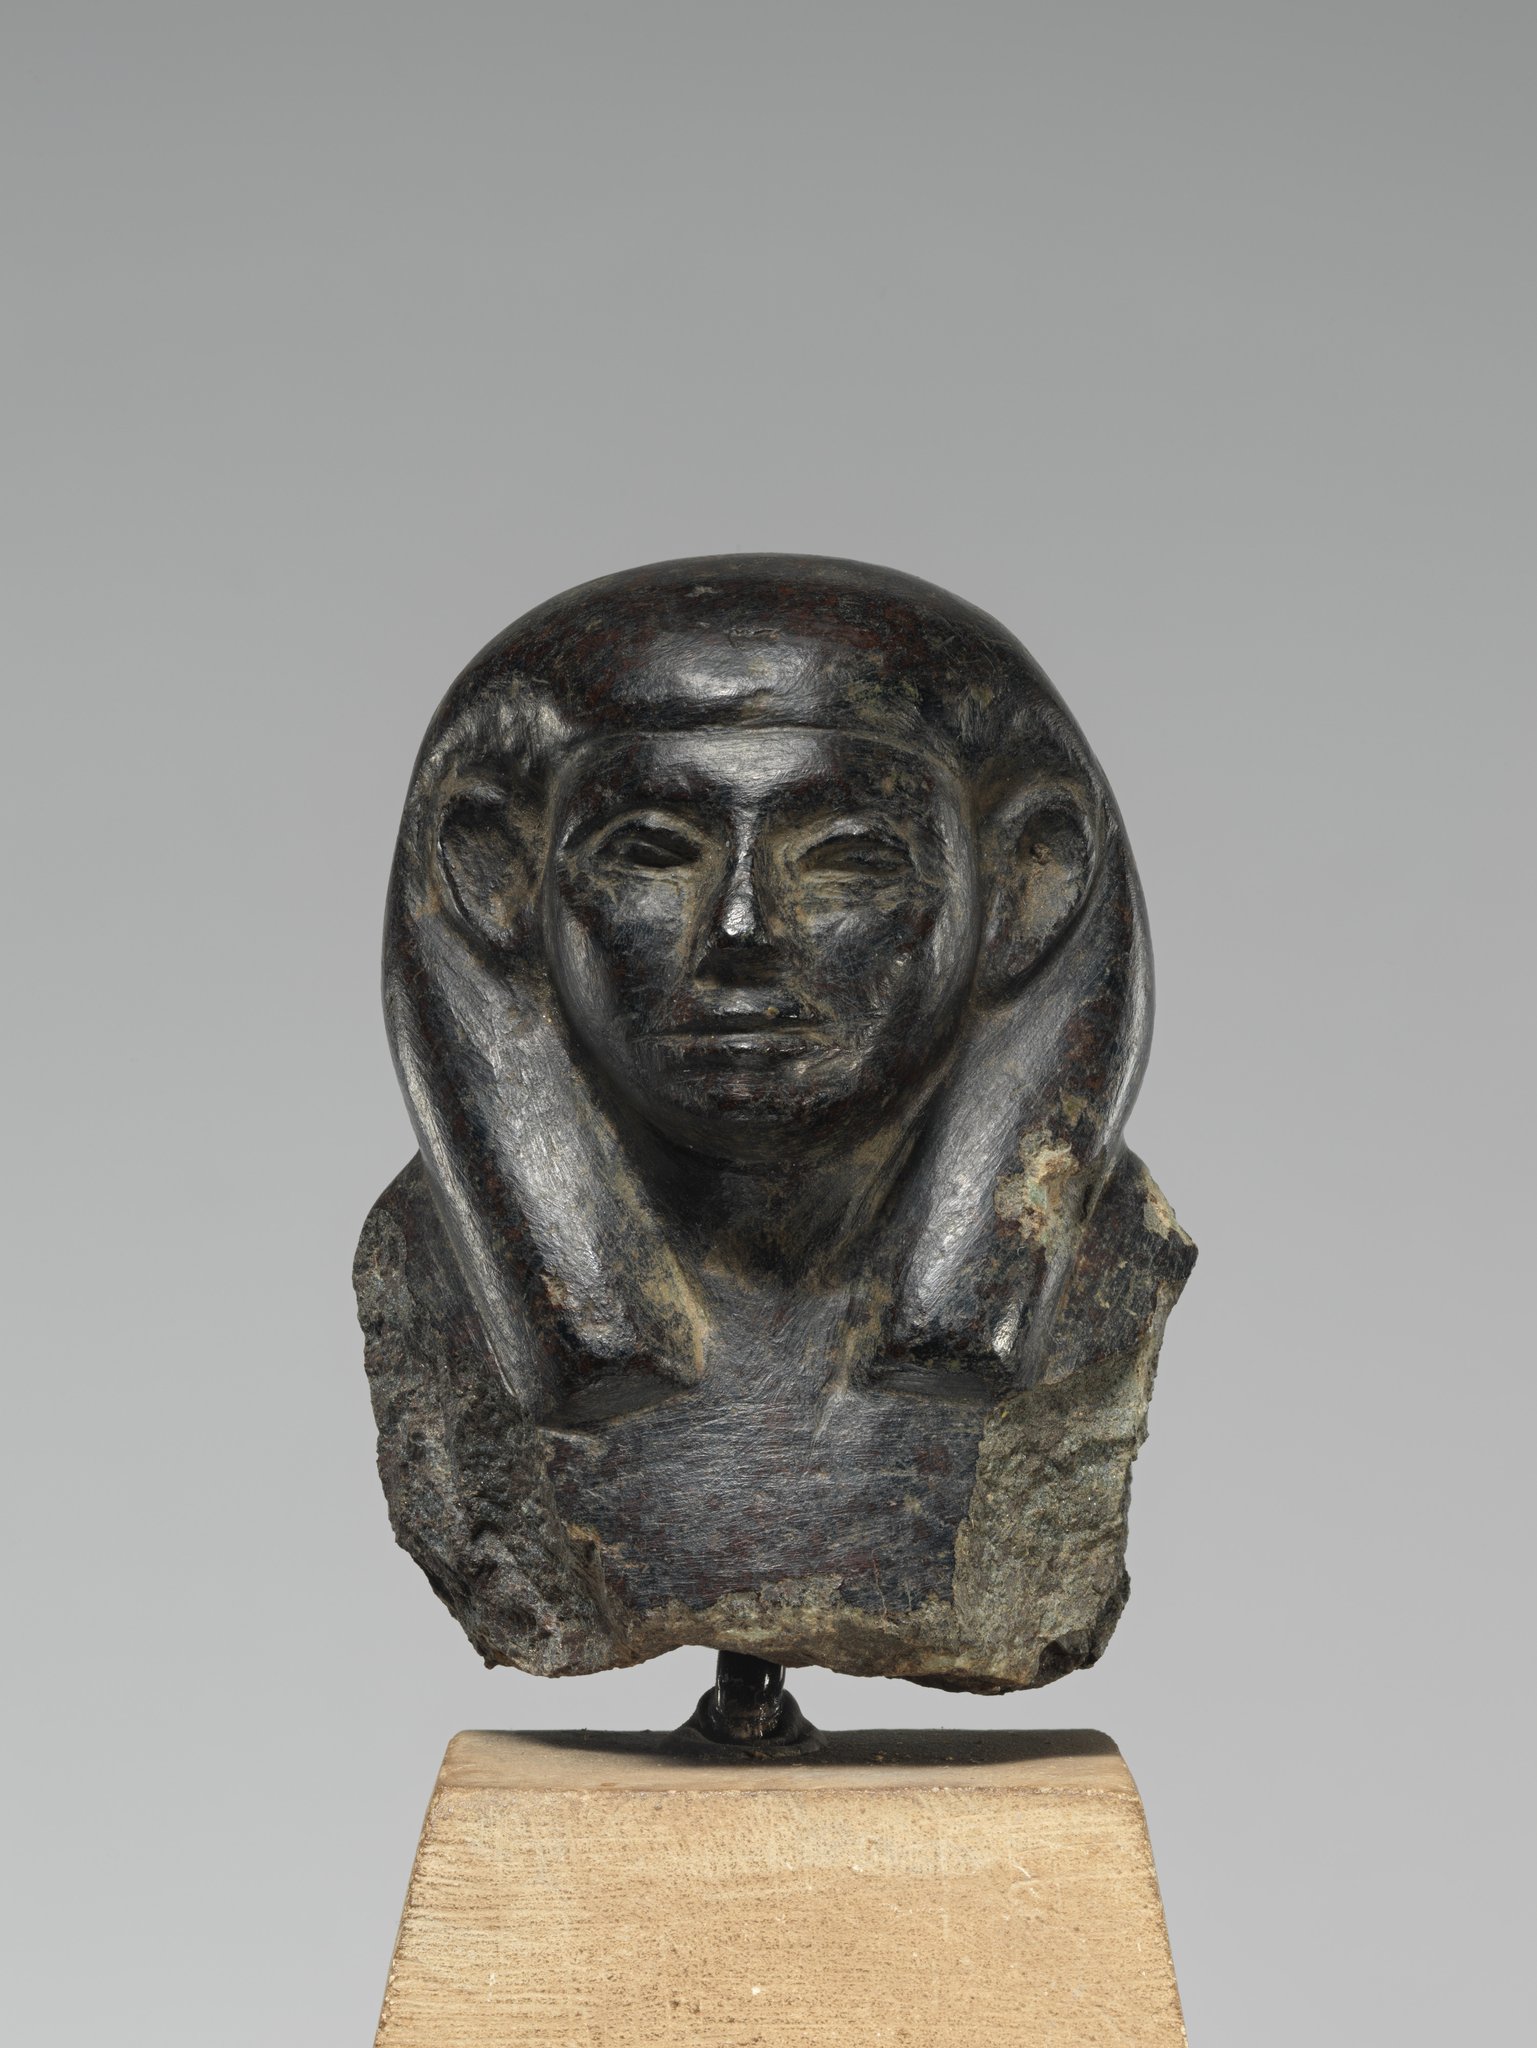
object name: head and chest of a shabti figure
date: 1850-1650 BCE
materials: stone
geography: egypt